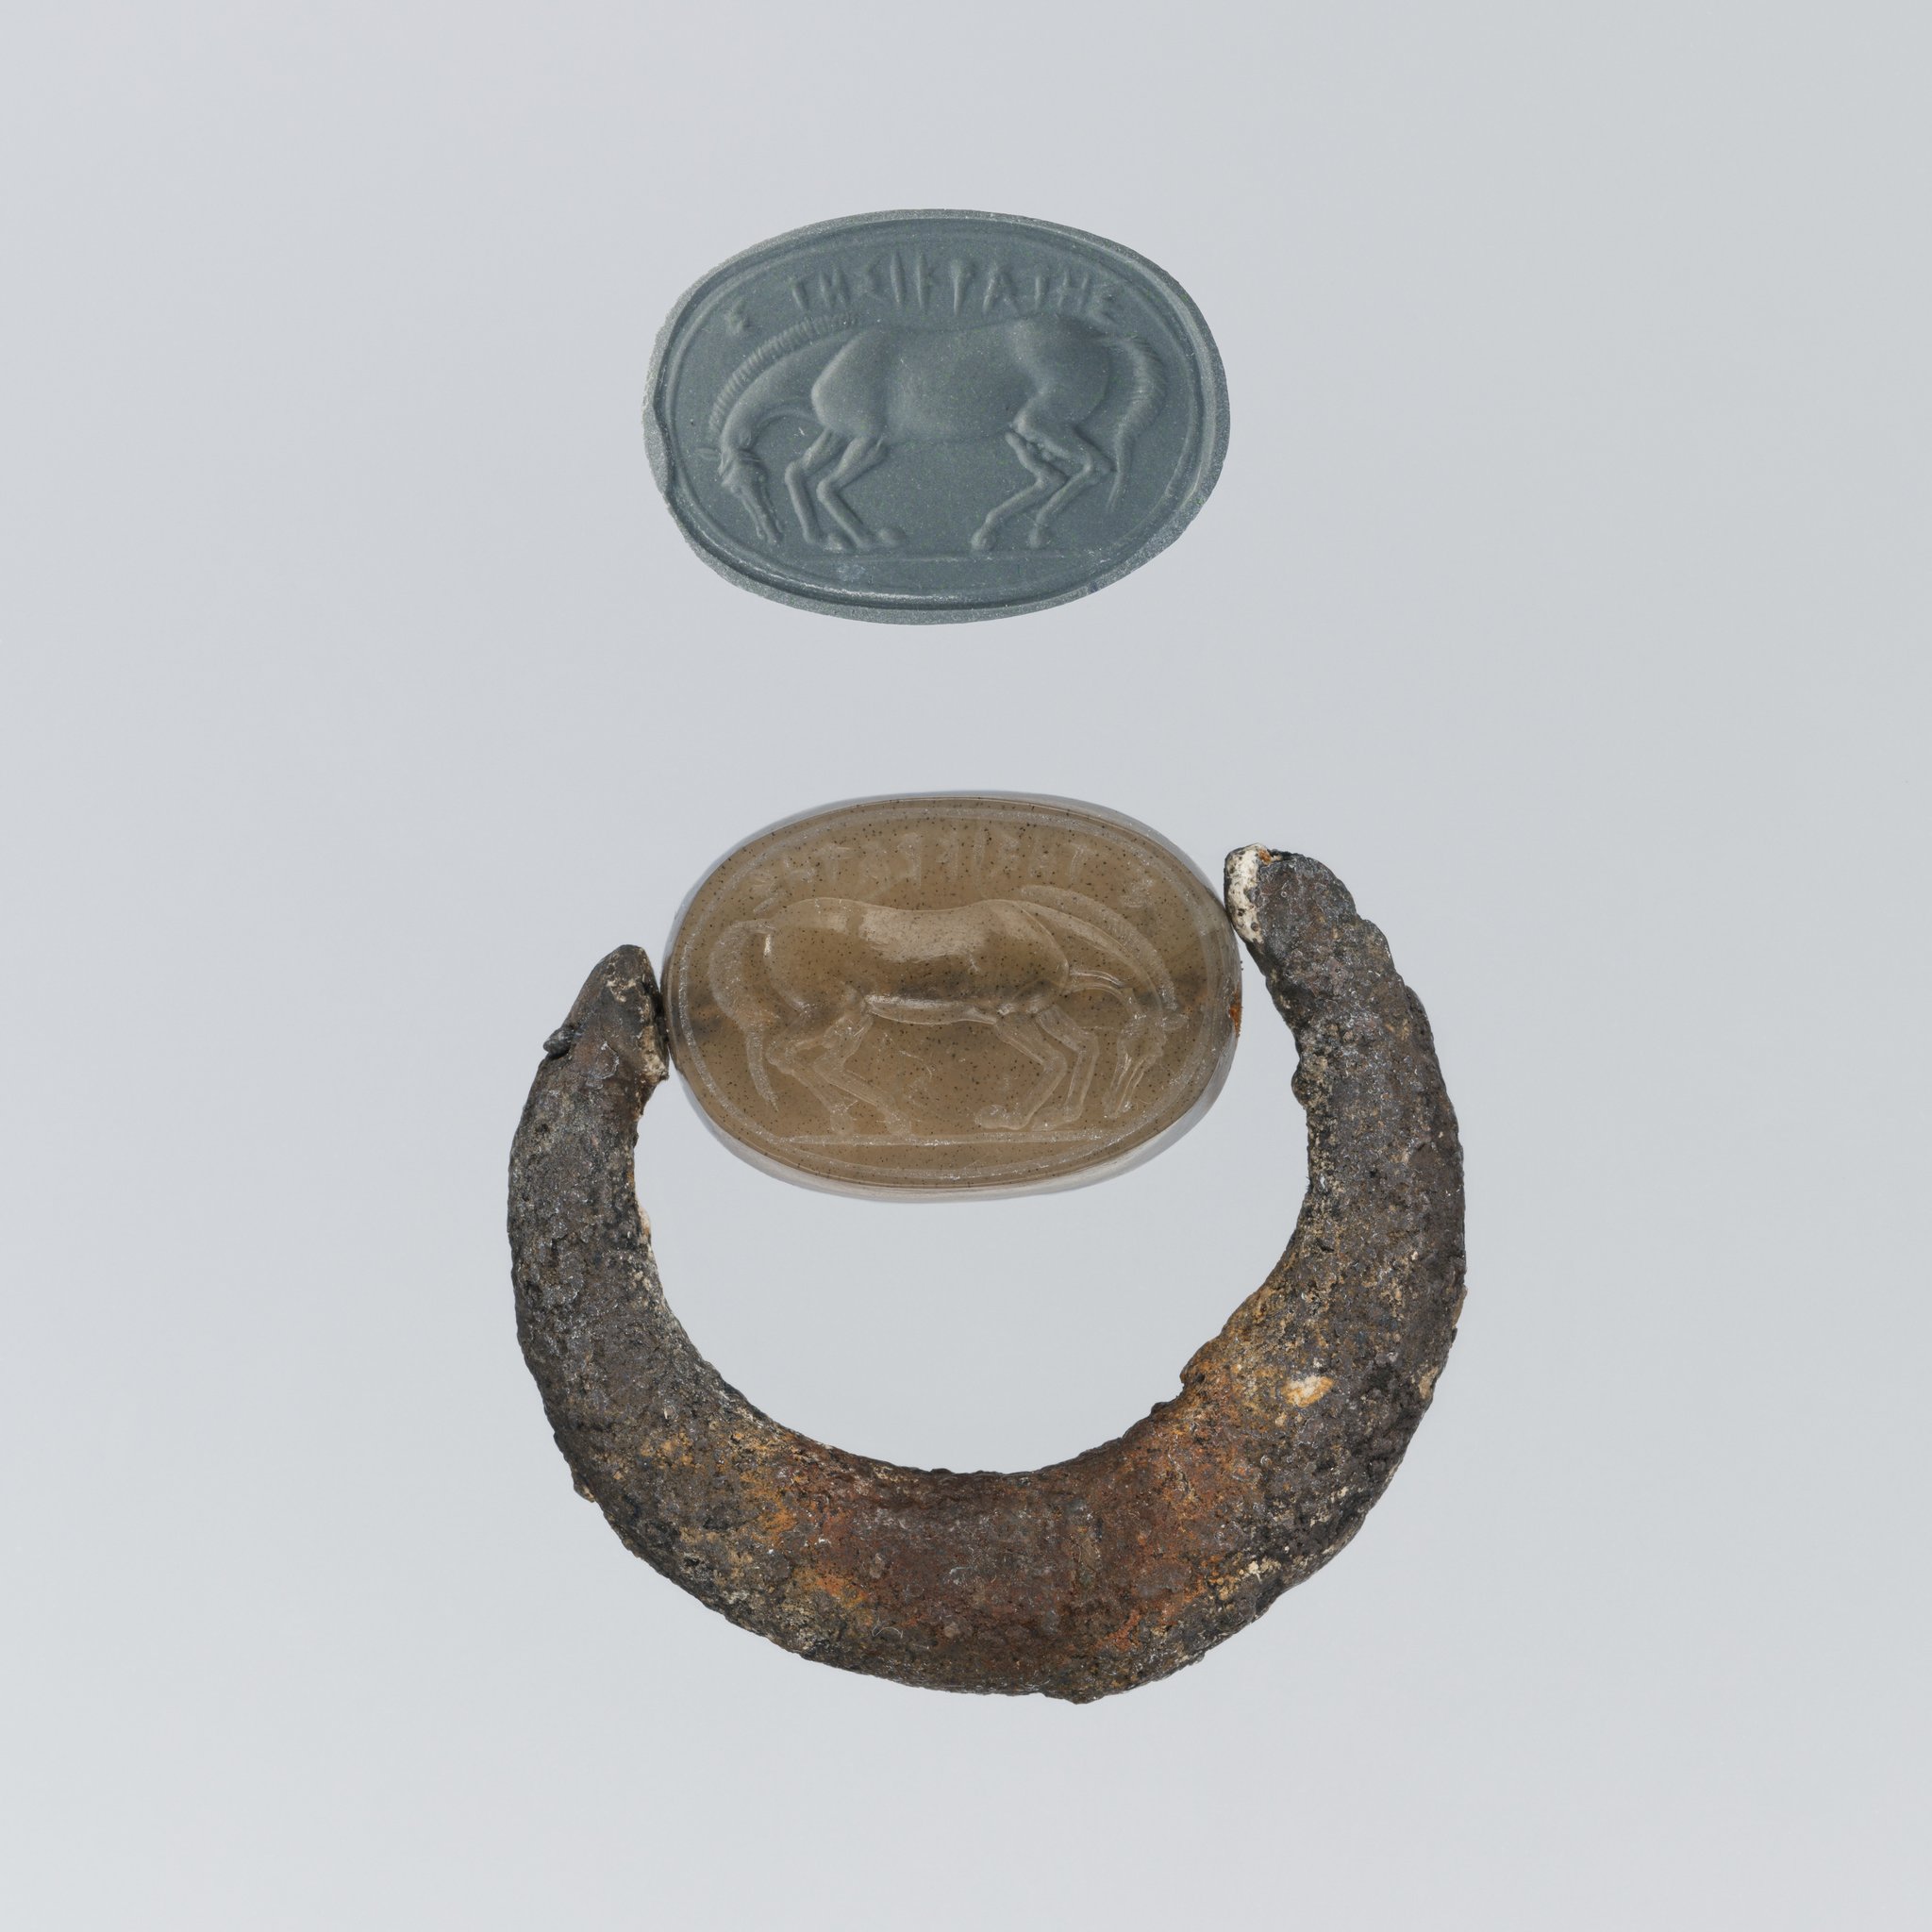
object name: ring with scaraboid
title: Silver ring with chalcedony scaraboid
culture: greek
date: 467-435 BCE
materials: stone, silver